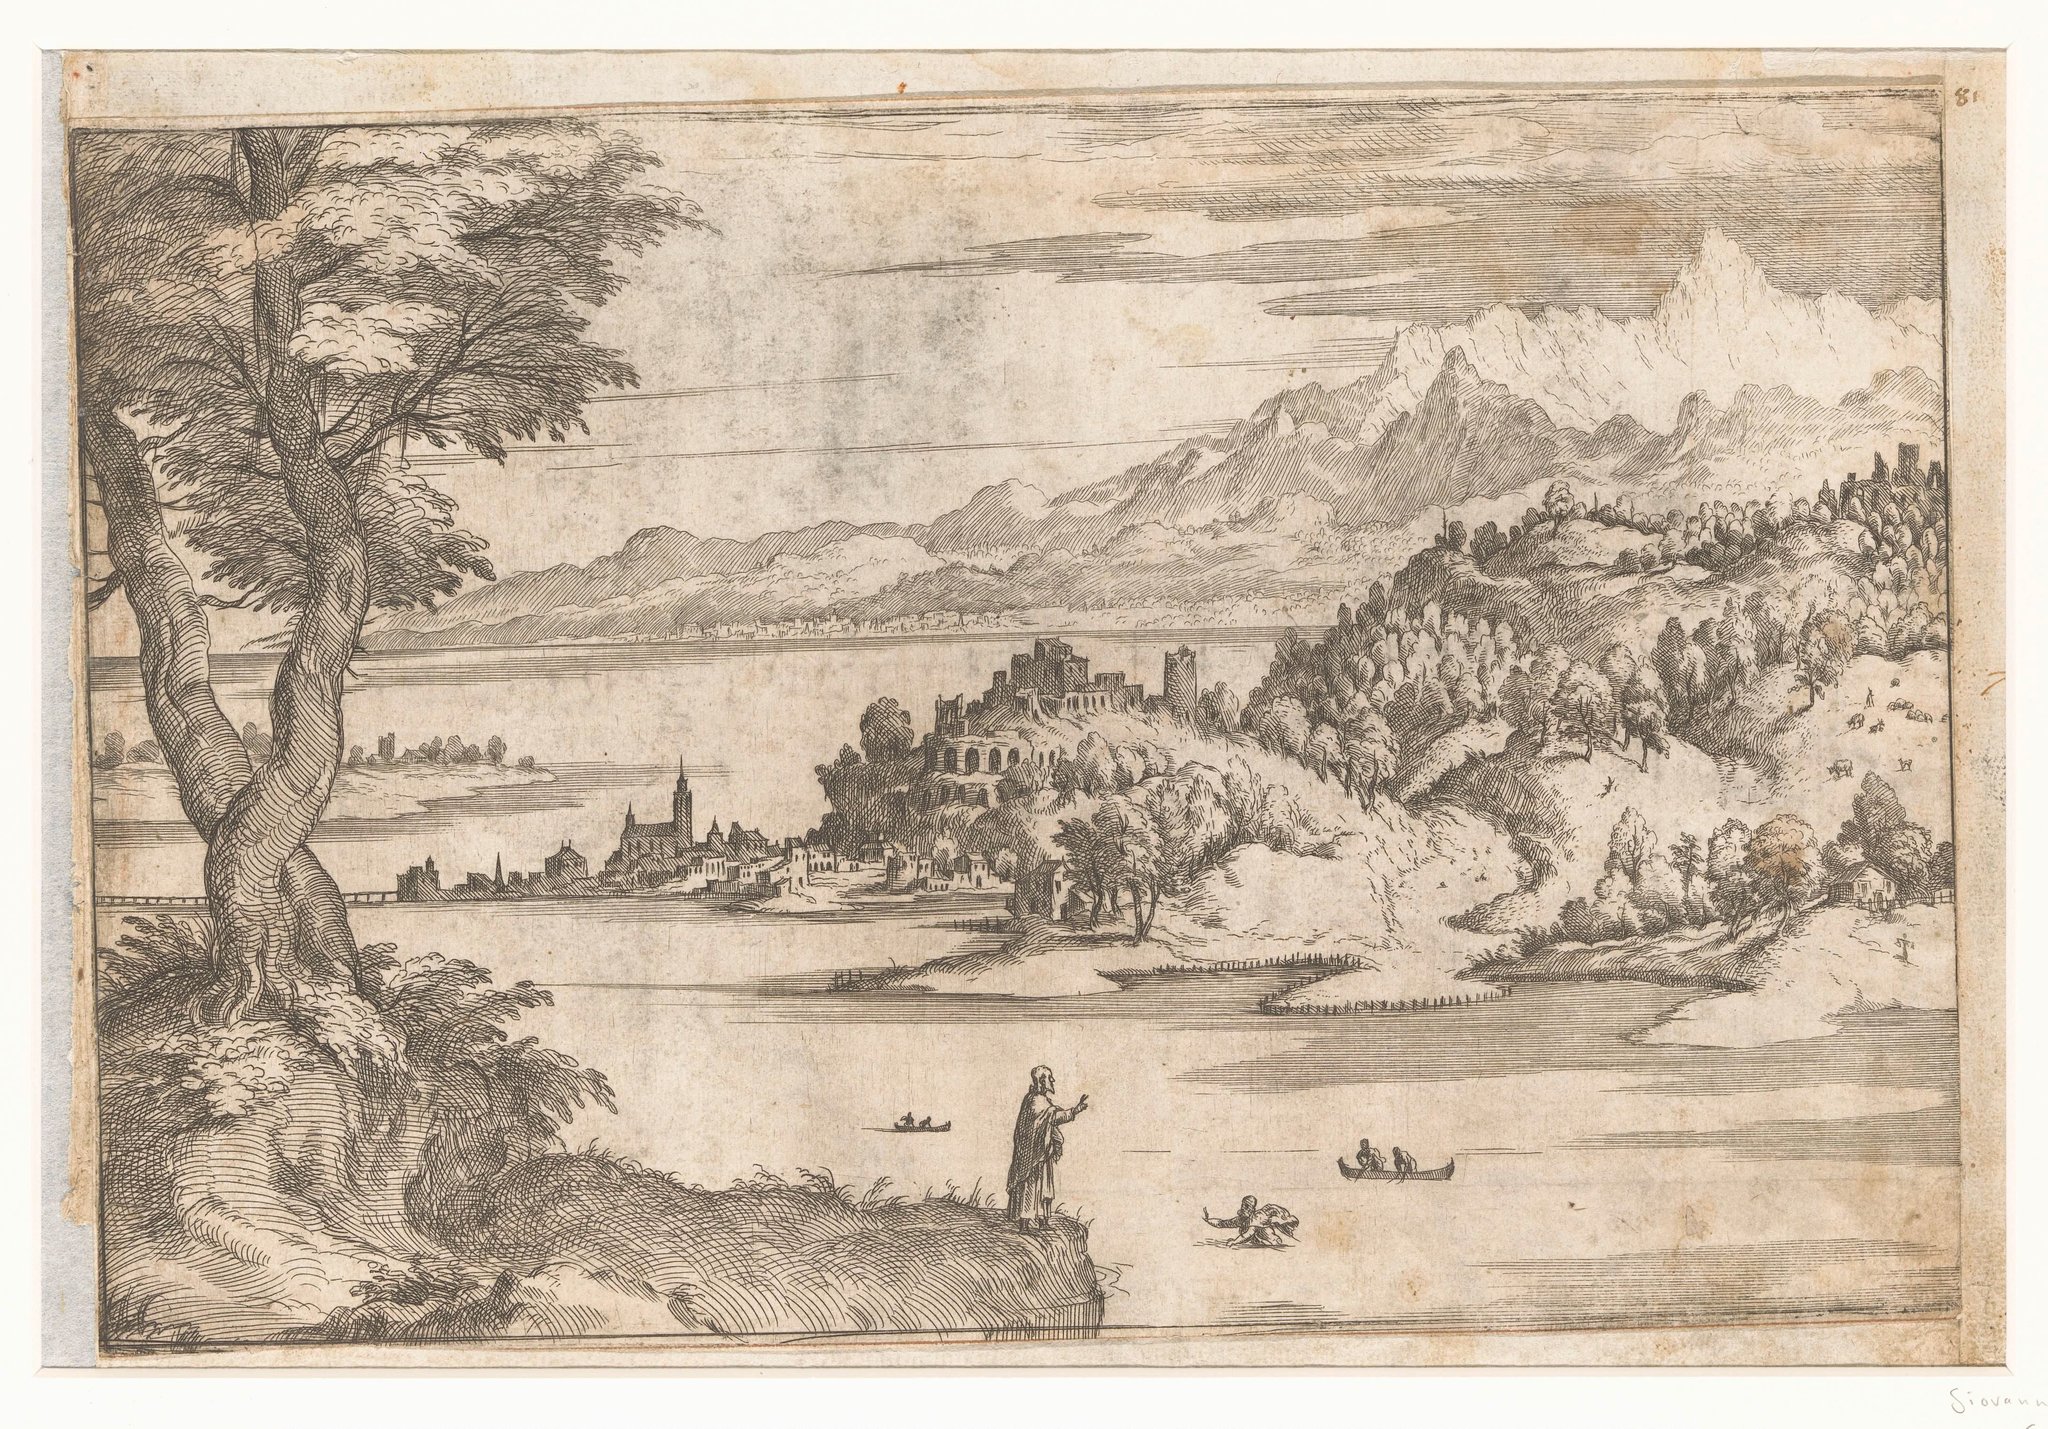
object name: print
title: Petrus loopt over het water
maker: giovanni battista fontana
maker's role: draughtsman, painter, print maker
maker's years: 1524-1587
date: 1535-1587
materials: paper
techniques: etching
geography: italy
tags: landscapes, river, peter steps out of the boat and tries to walk on the water towards christ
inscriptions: number: ‘77, 81’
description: Christus staat aan de oever. Petrus probeert over het water te lopen, terwijl vier vissers in twee bootjes op het water drijven (Mt. 14: 31). Op de andere oever is een stad zichtbaar die overloopt in een beboste heuvelrug. Op de achtergrond bevindt zich een gebergte. De voorgrond links wordt gedomineerd door een boom.